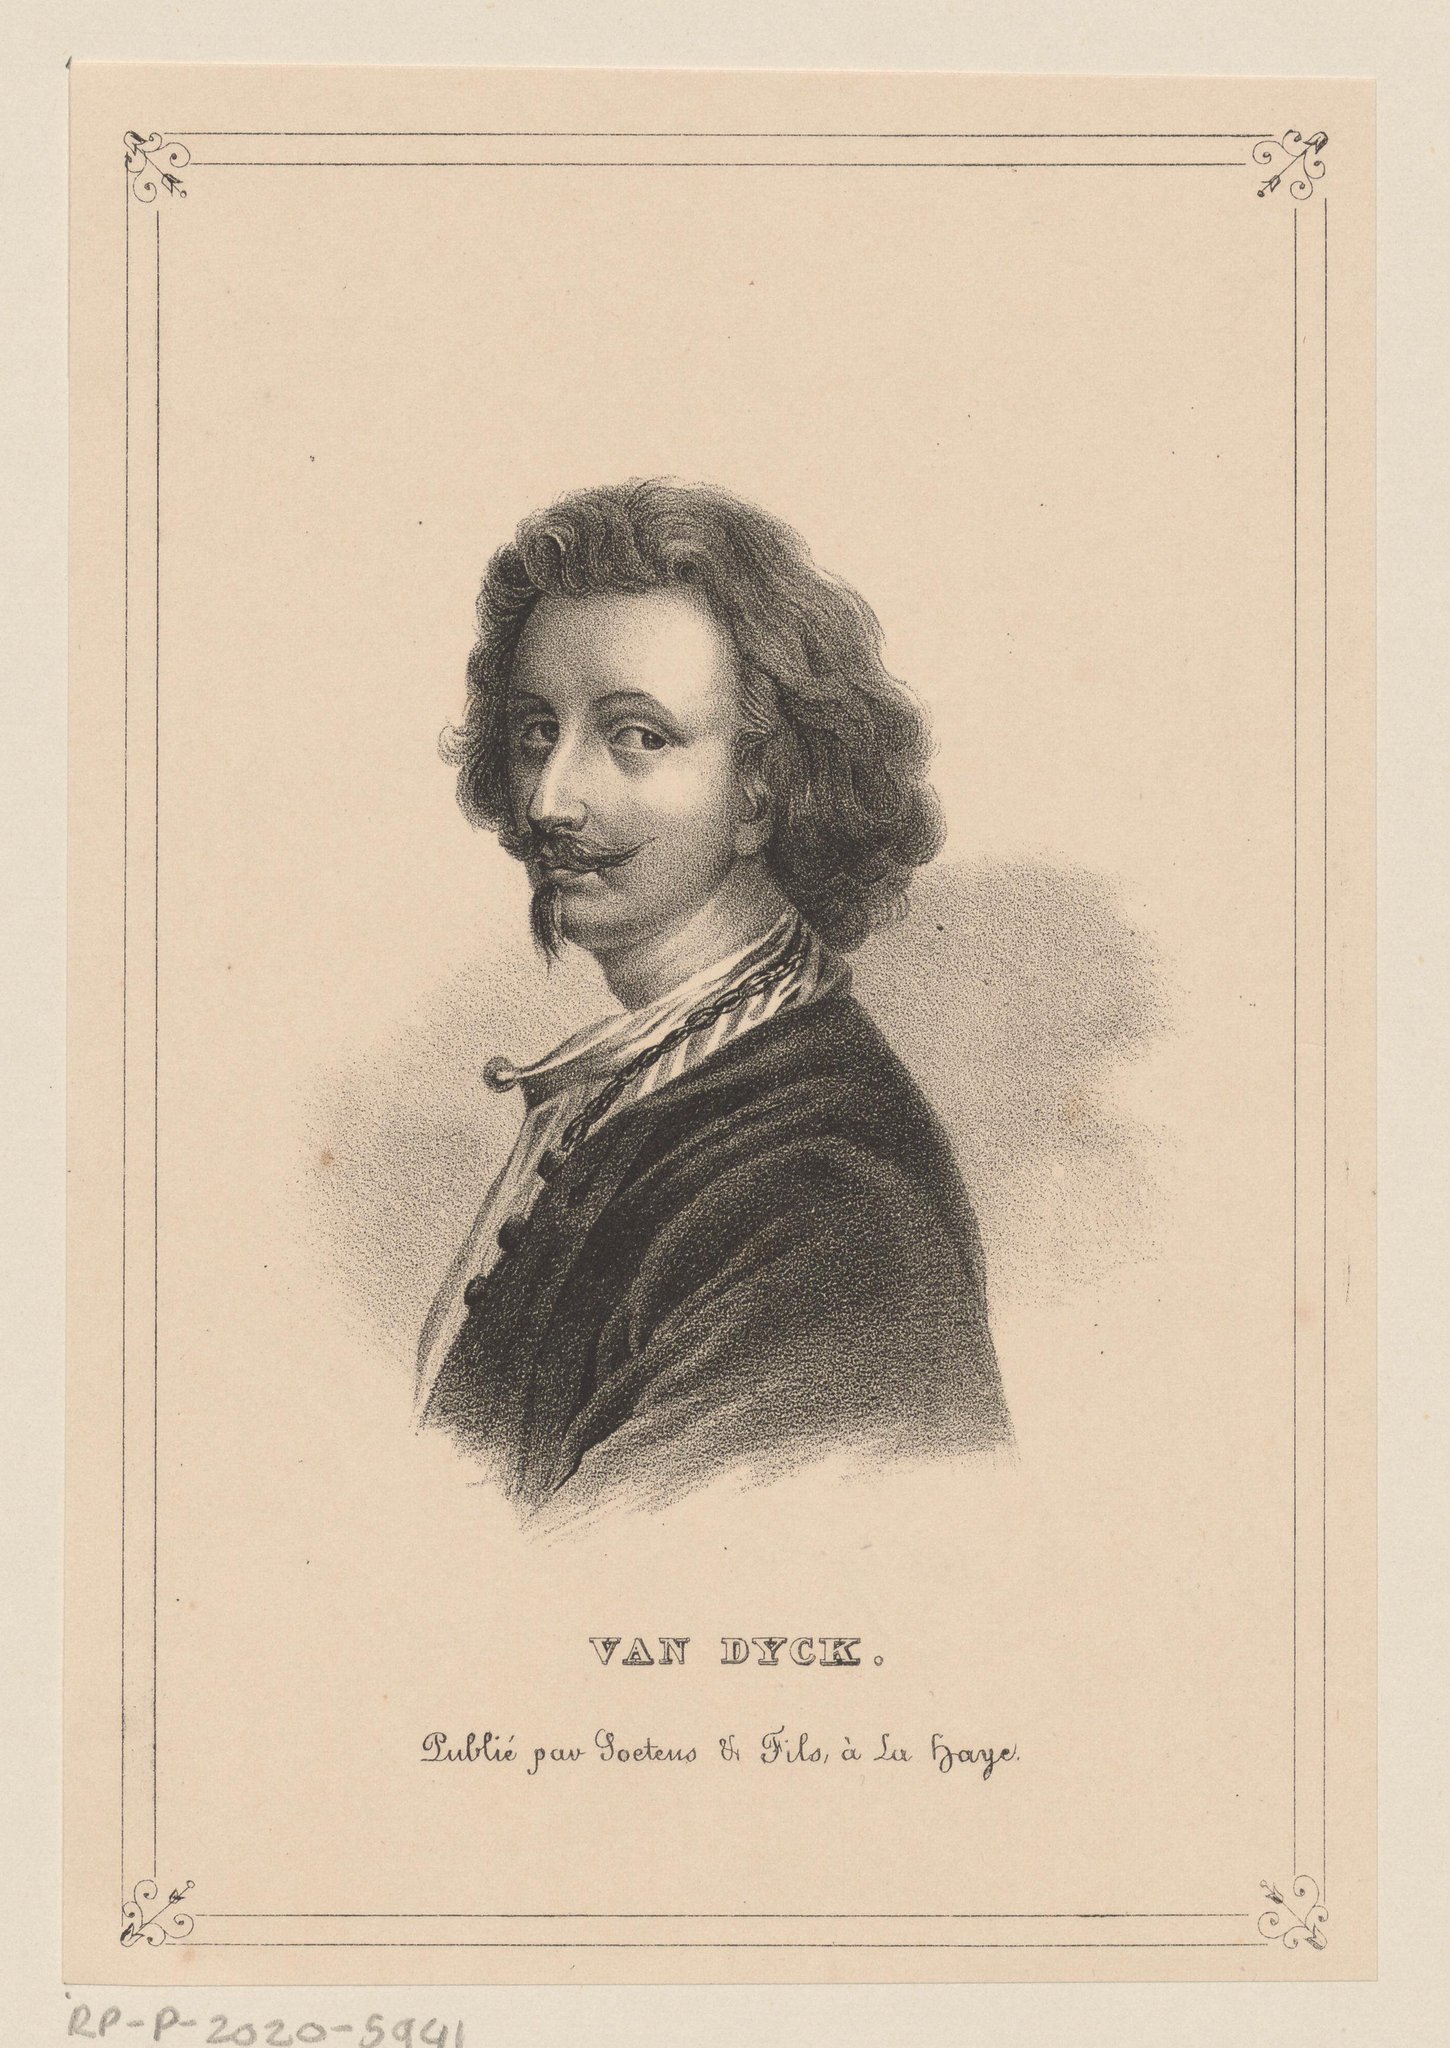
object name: print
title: Portret van Anthony van Dyck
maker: Anonymous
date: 1837-1840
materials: paper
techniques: lithograph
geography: the hague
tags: antwerp, london, painter, print maker, draughtsman, anthony van dyck, historical persons, portrait, self-portrait of painter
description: Deze prent maakt mogelijk deel uit van een serie uitgegeven door Soetens et Fils omstreeks 1838, opgedragen aan de Prins van Oranje. In de 'Prospectus en Inteekenlijst' stond vermeld dat de serie bestond uit een onbepaald aantal portretten, waarvan er drie of vier per maand verschenen.